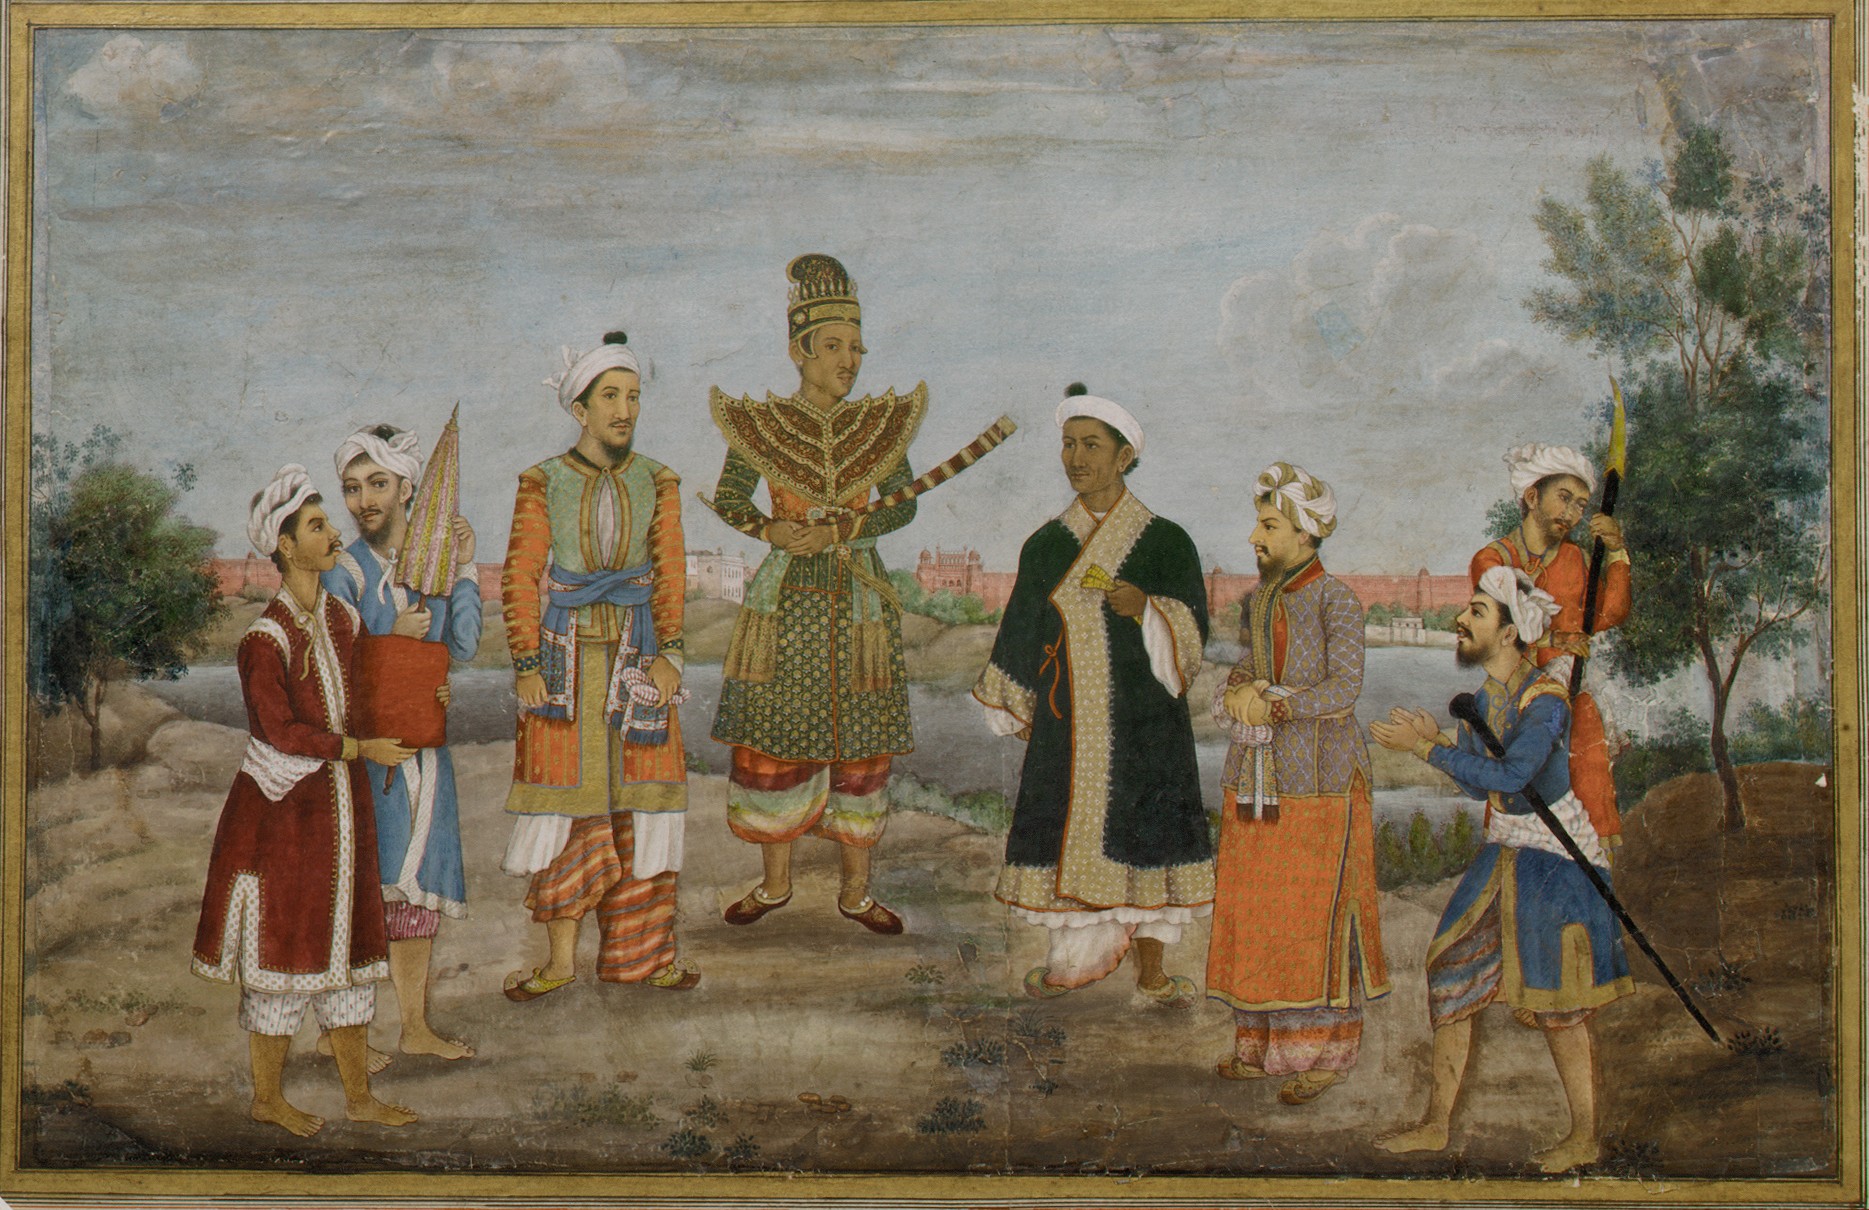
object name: illustrated single work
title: Eight Men in Indian and Burmese Costume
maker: ghulam ‘ali khan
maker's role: artist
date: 1801-1900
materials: gold, ink, paper, watercolor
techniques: dyeing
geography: india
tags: men